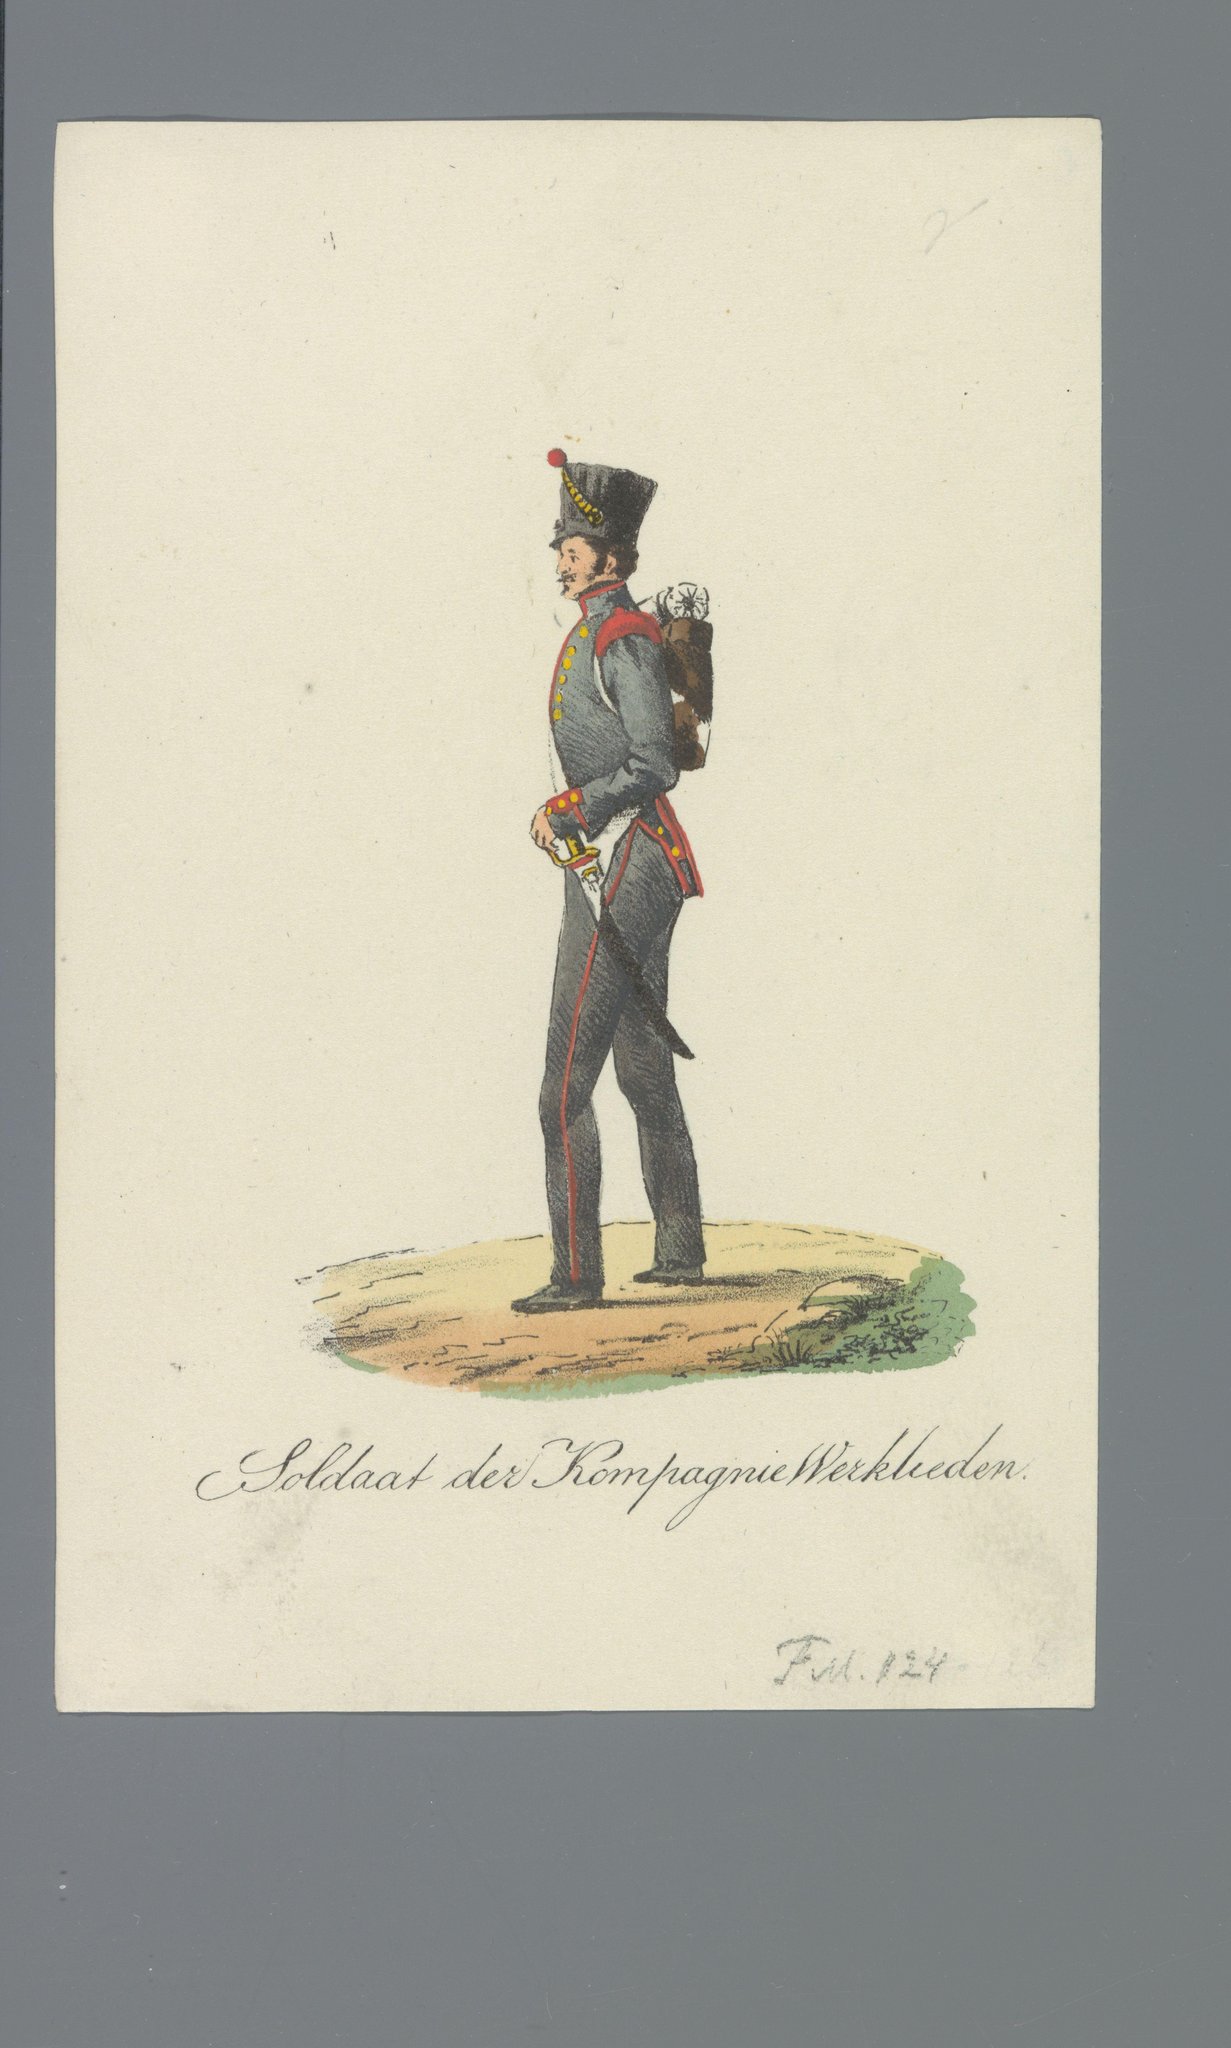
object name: print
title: Soldaat der Kompagnie Werklieden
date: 1835-1850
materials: paper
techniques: hand coloring, lithograph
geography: utrecht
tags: (military) uniforms, clothes, costume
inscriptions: collector's mark: Lugt 2228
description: Een soldaat van de Compagnie Werklieden, te voet. Onderdeel van een serie van 157 losse bladen met Nederlandse militaire uniformen in de jaren 1830-1832.